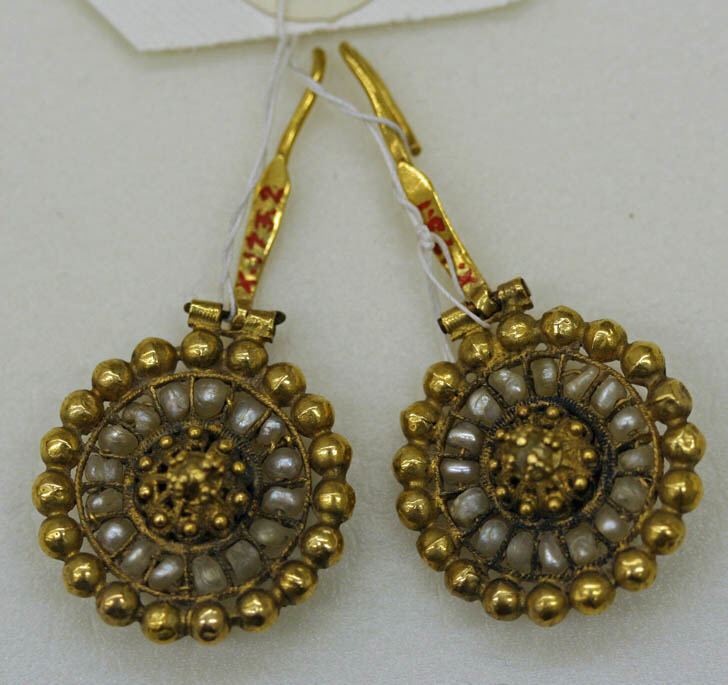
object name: earring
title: Earrings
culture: austrian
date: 1801-1900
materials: metal, pearl